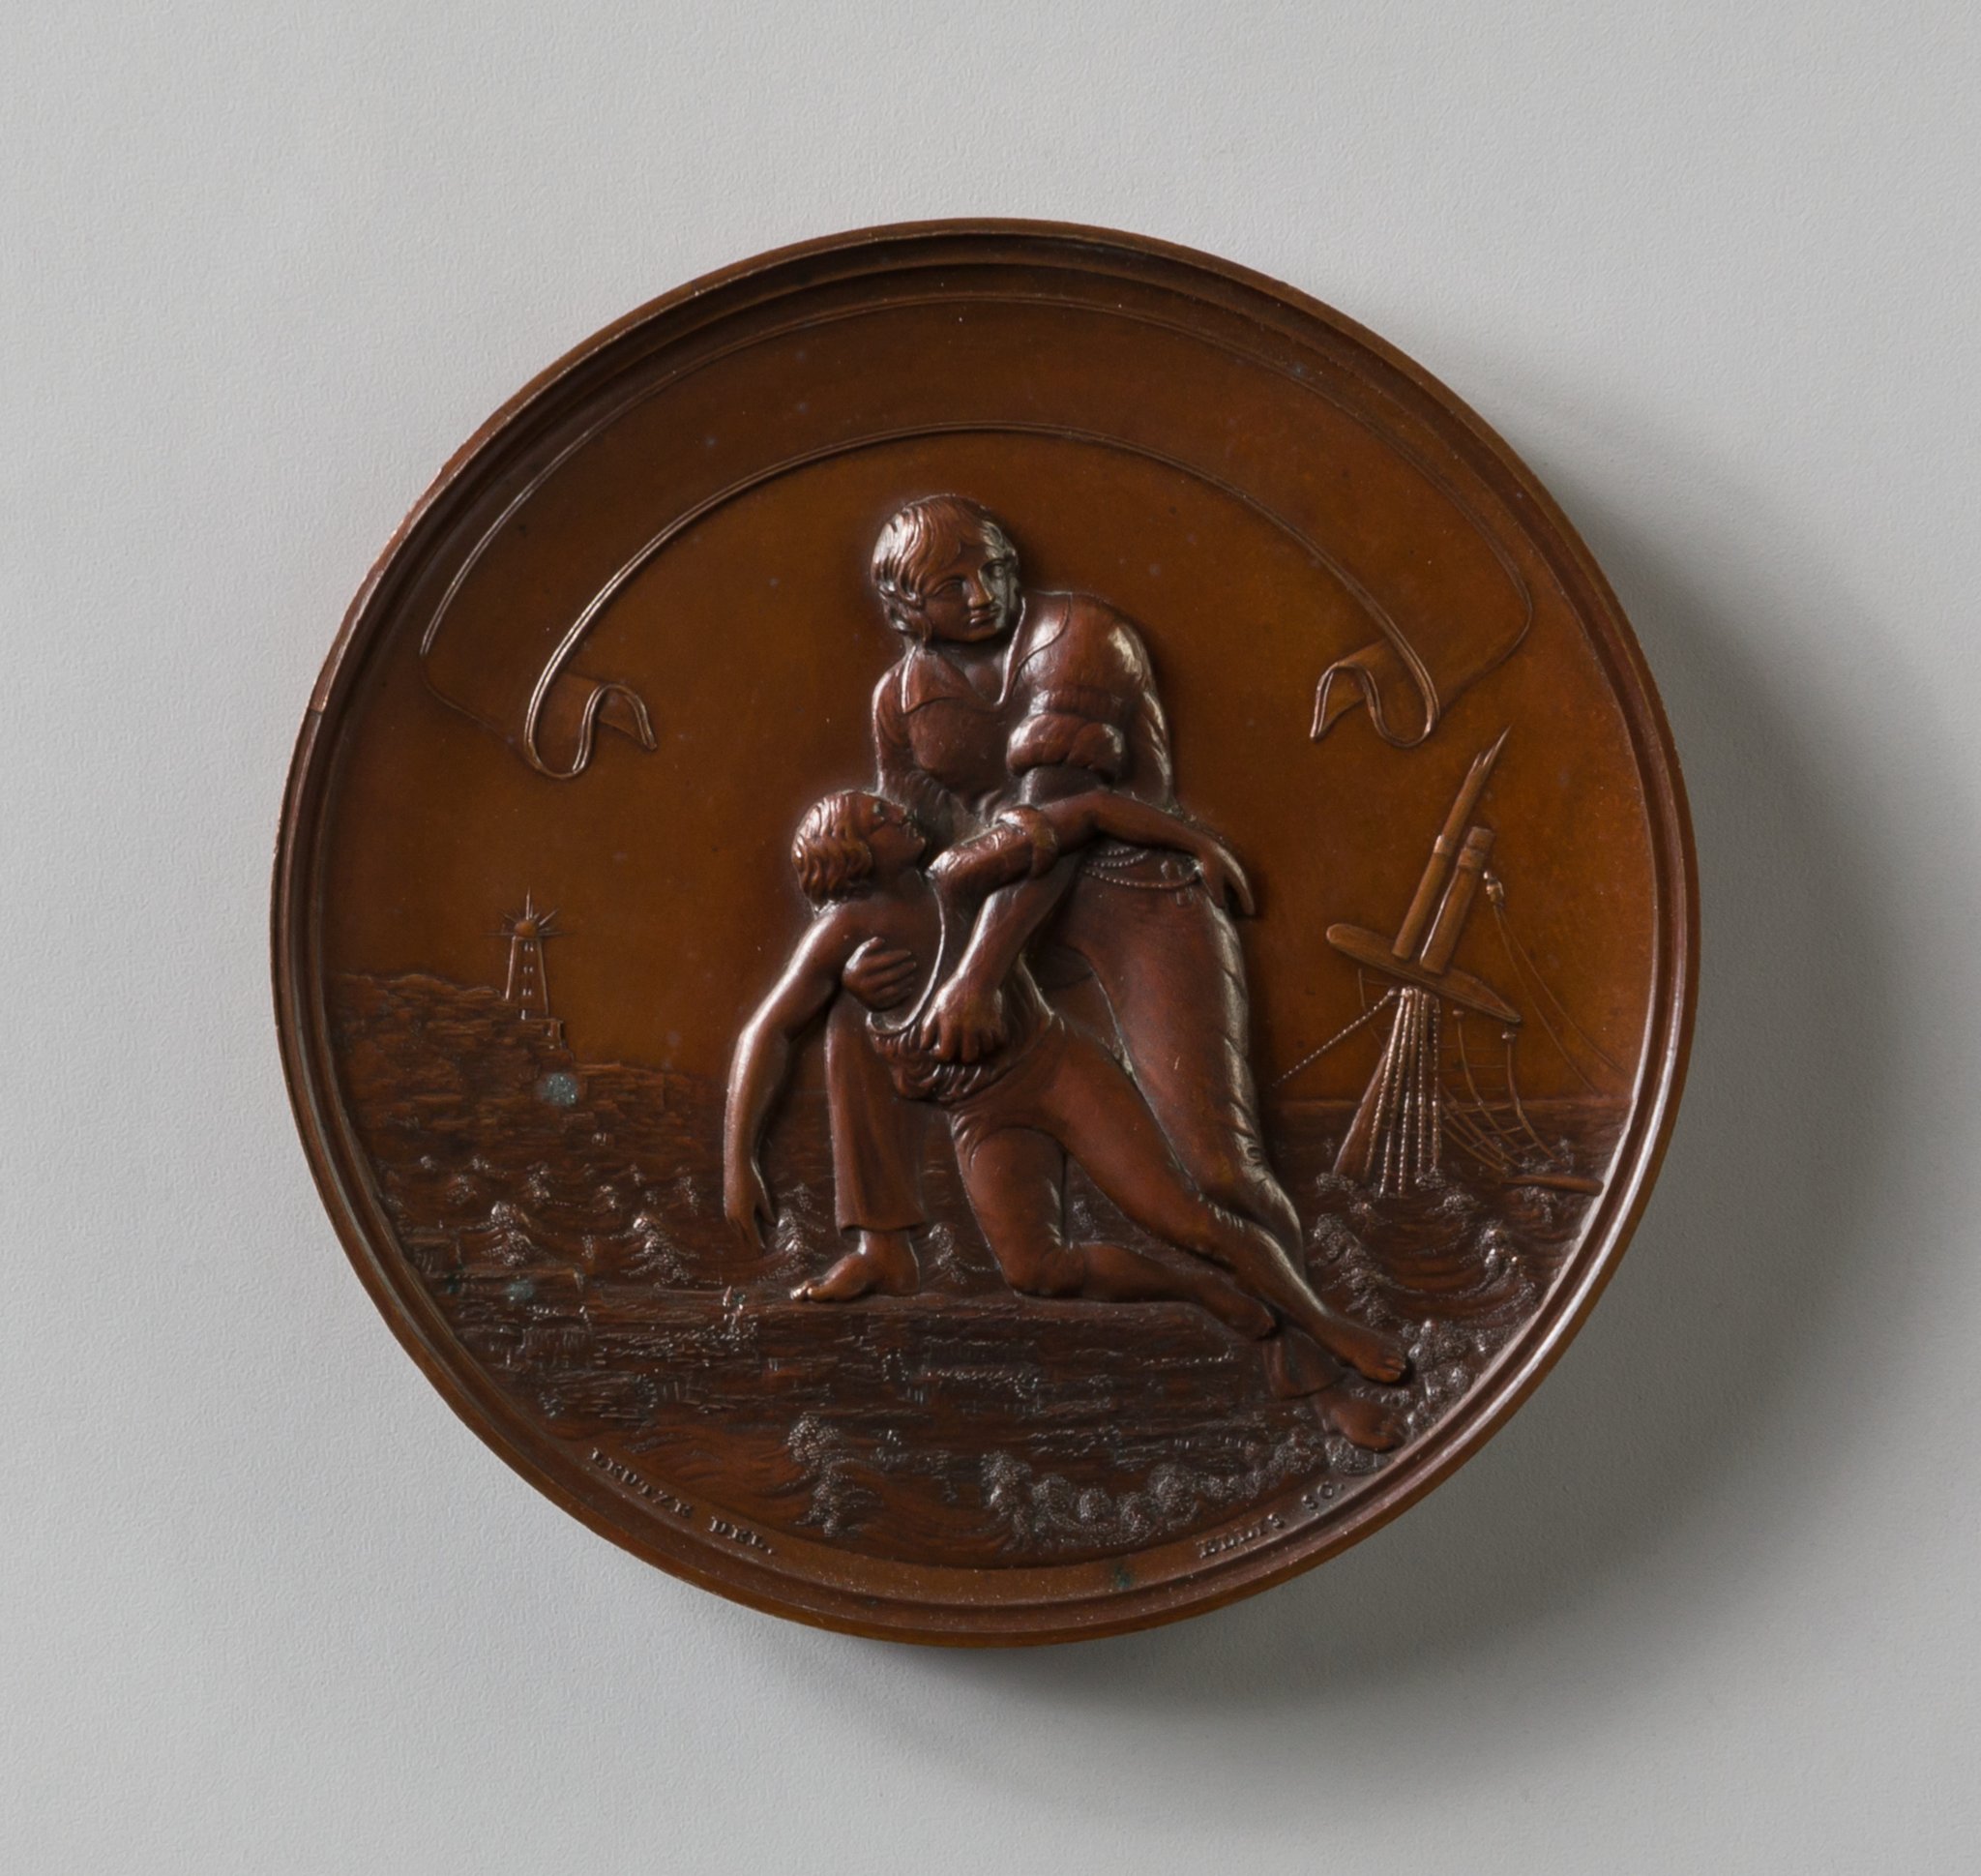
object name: medal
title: The "Shipwreck Medal"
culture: american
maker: salathiel ellis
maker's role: maker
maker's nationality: american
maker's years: 1803-1879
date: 1845-1857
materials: bronze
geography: united states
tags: shipwrecks,men